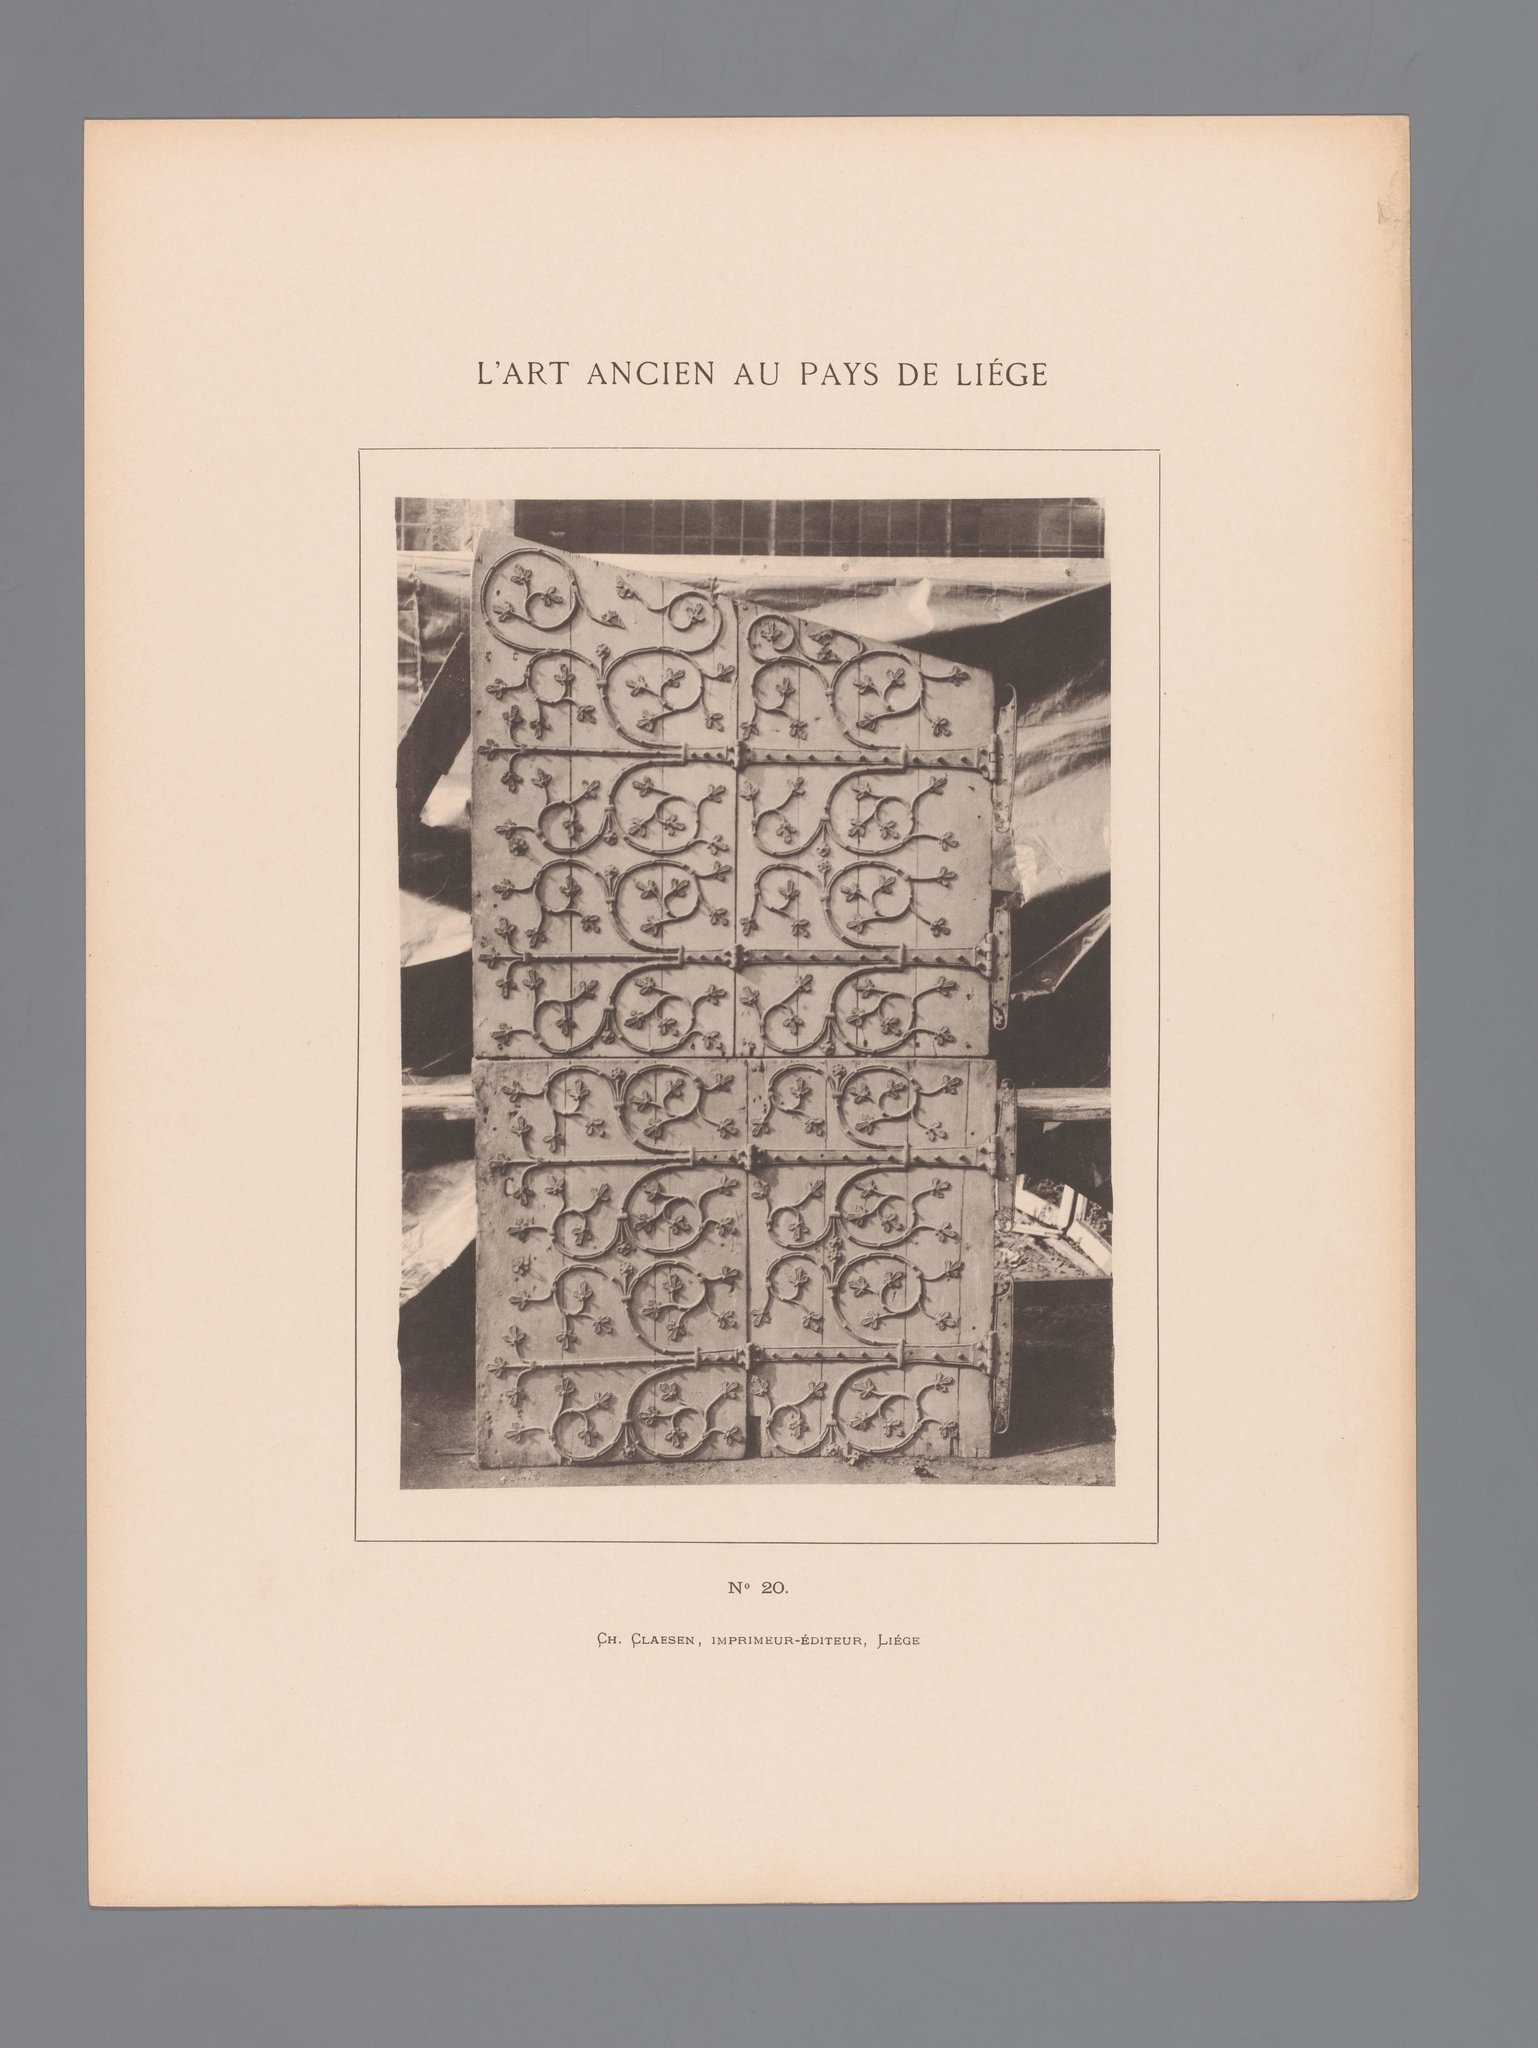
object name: photomechanical print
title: L'Art Ancien au Pays de Liége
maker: Anonymous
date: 1879-1884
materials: paper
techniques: photograph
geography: liège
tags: door, liège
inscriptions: number: ‘No 20’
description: Deze prent maakt deel uit van een omslag met twintig prenten, een titelblad en een lijst van afbeeldingen.